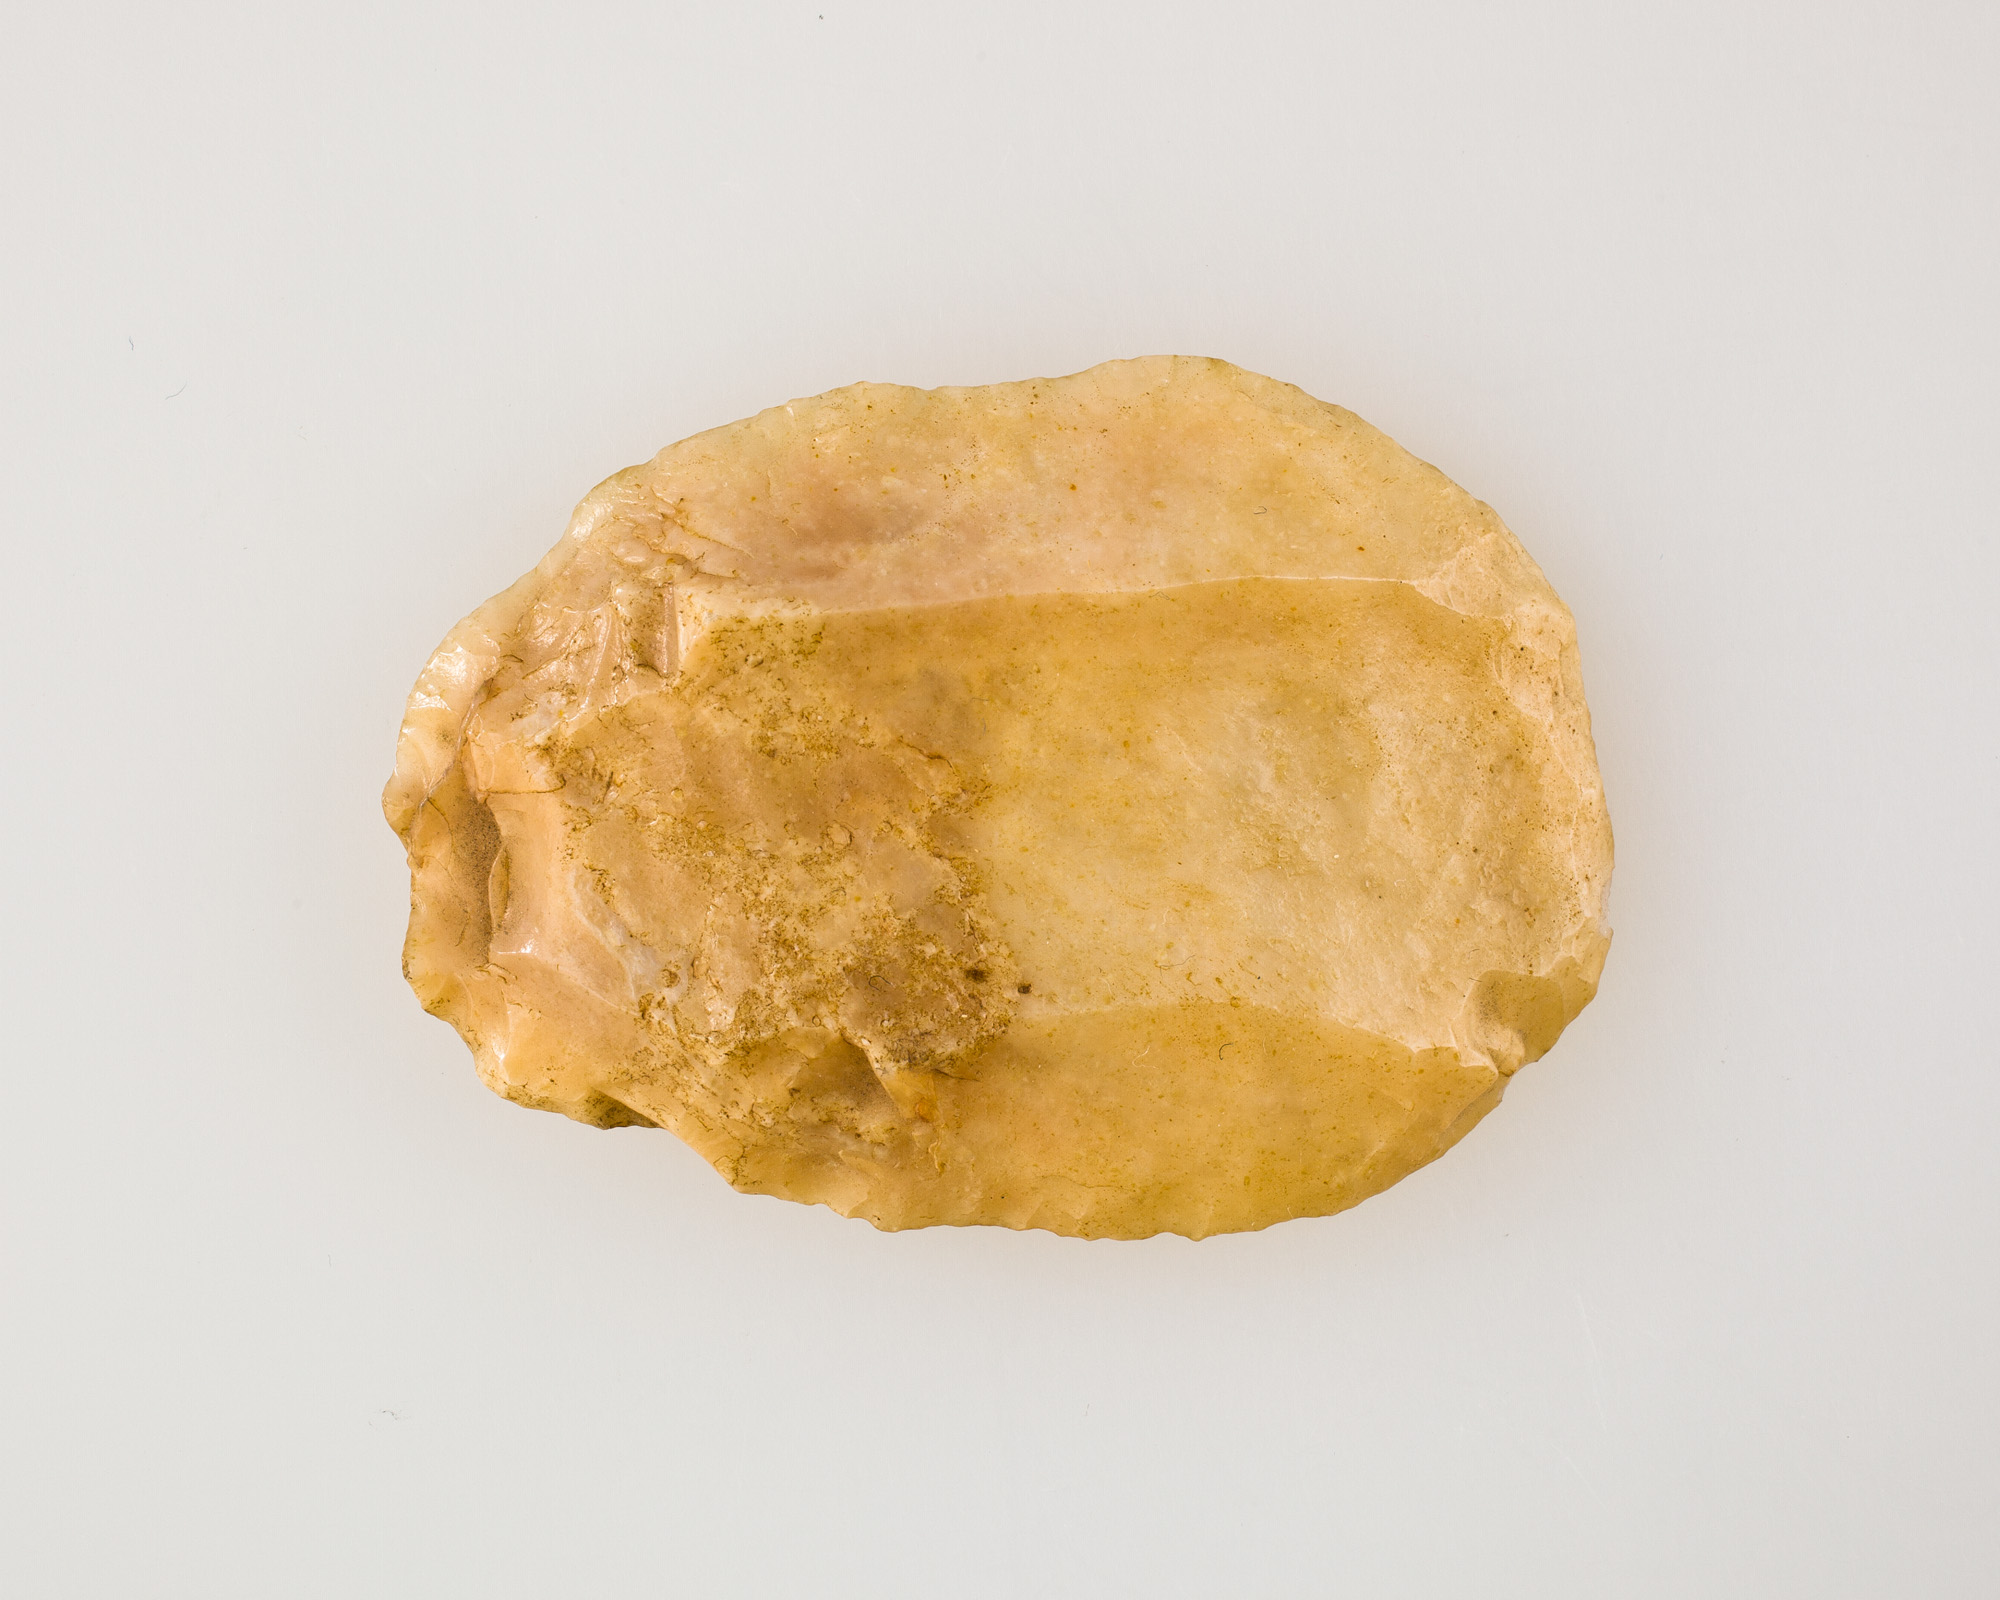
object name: tool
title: Tool (?)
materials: stone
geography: egypt